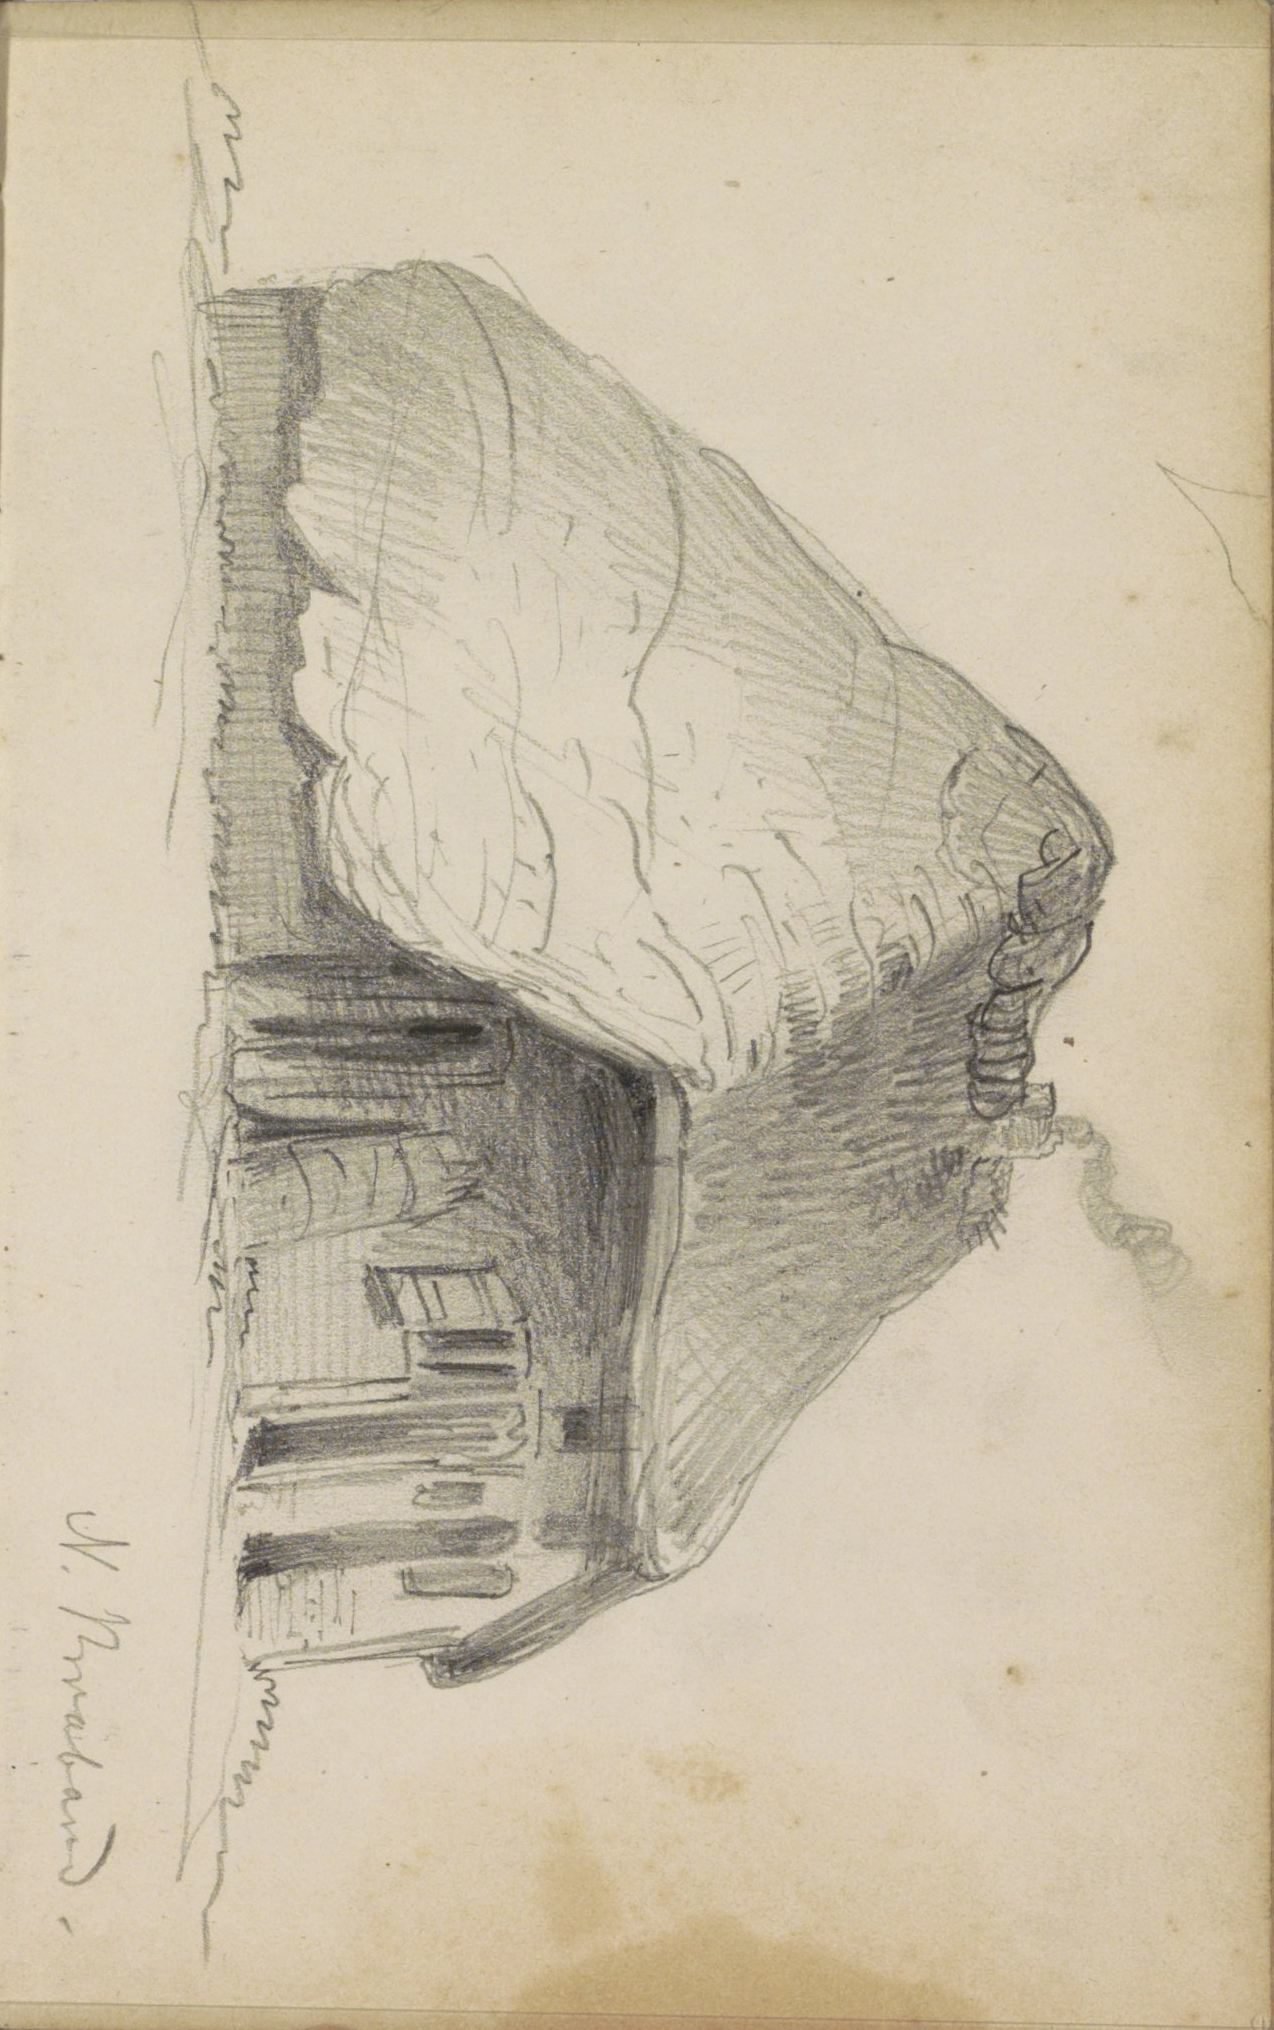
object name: sketchbook leaf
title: Hut met rieten kap in Noord-Brabant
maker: johannes tavenraat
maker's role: draughtsman, painter, print maker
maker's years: 1809-1881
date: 1839-1872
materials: paper, pencil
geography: north brabant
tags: farm (building)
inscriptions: annotation: ‘N. Braband.’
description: Blad 33 recto uit een schetsboek met 73 bladen.